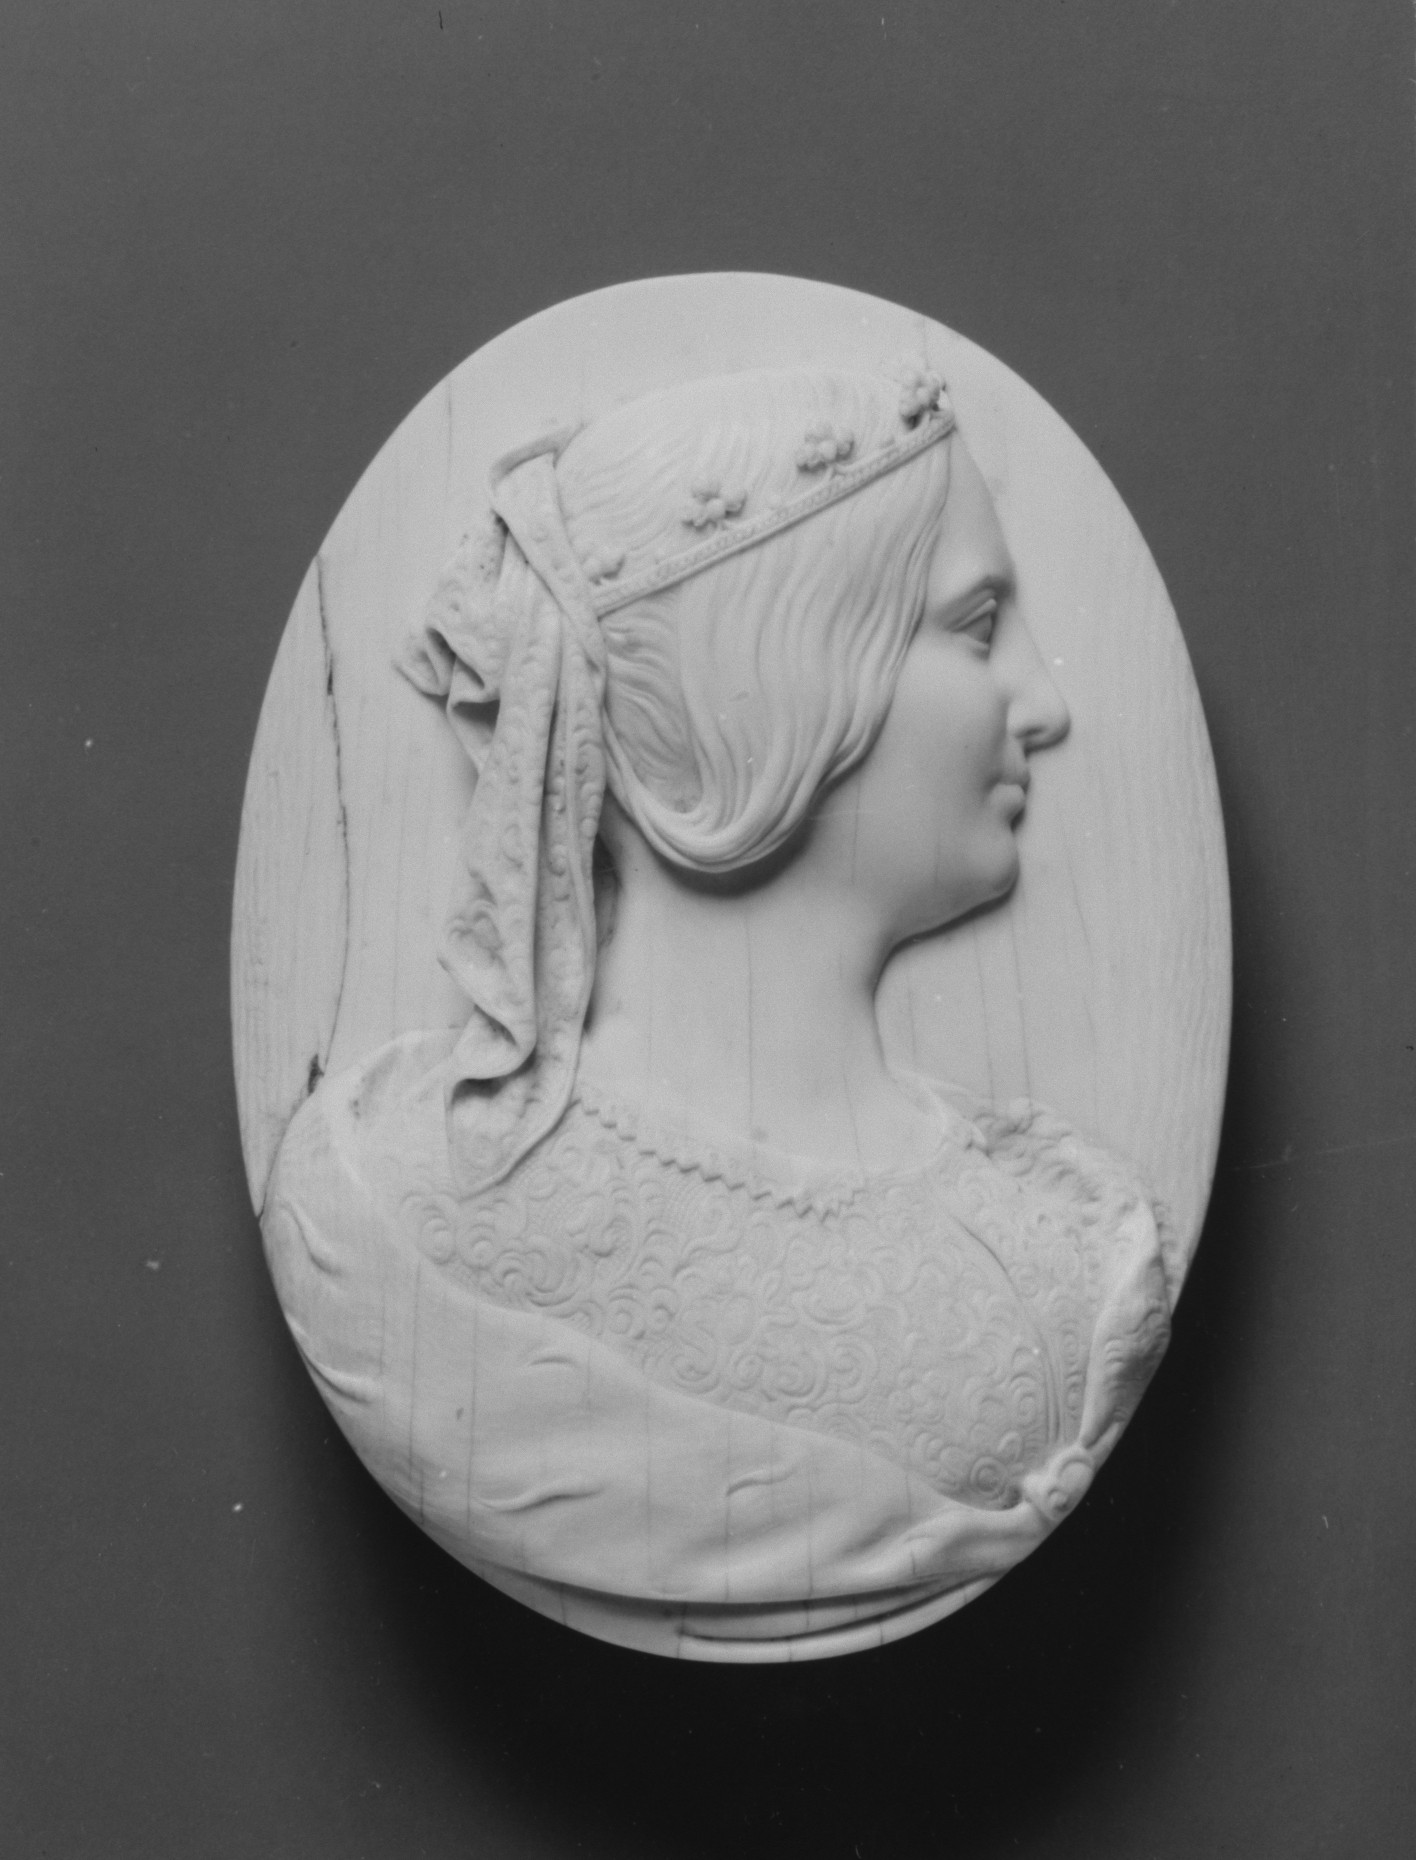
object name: relief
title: Portrait of a Lady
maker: norbert michael schrödl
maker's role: artist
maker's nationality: austrian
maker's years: 1816-1890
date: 1850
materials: ivory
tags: profiles,women